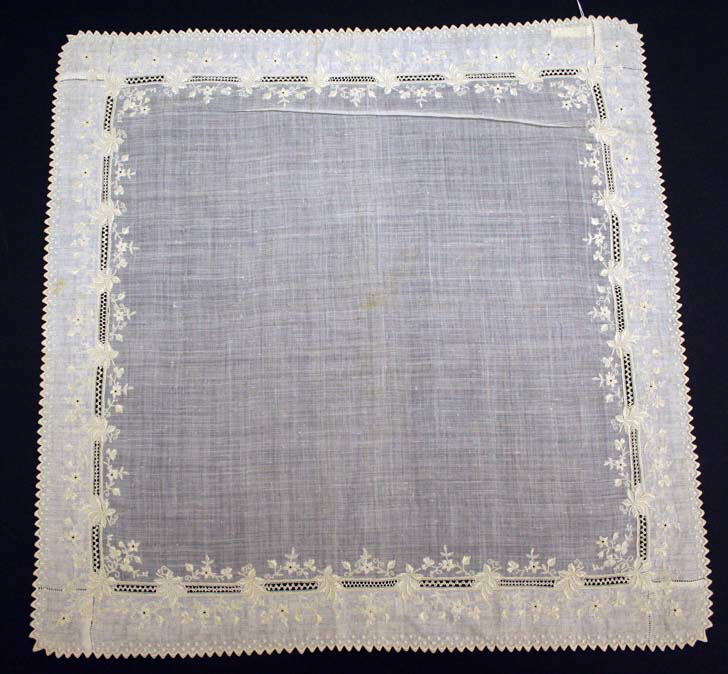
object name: handkerchief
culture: french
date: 1880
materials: linen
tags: flowers